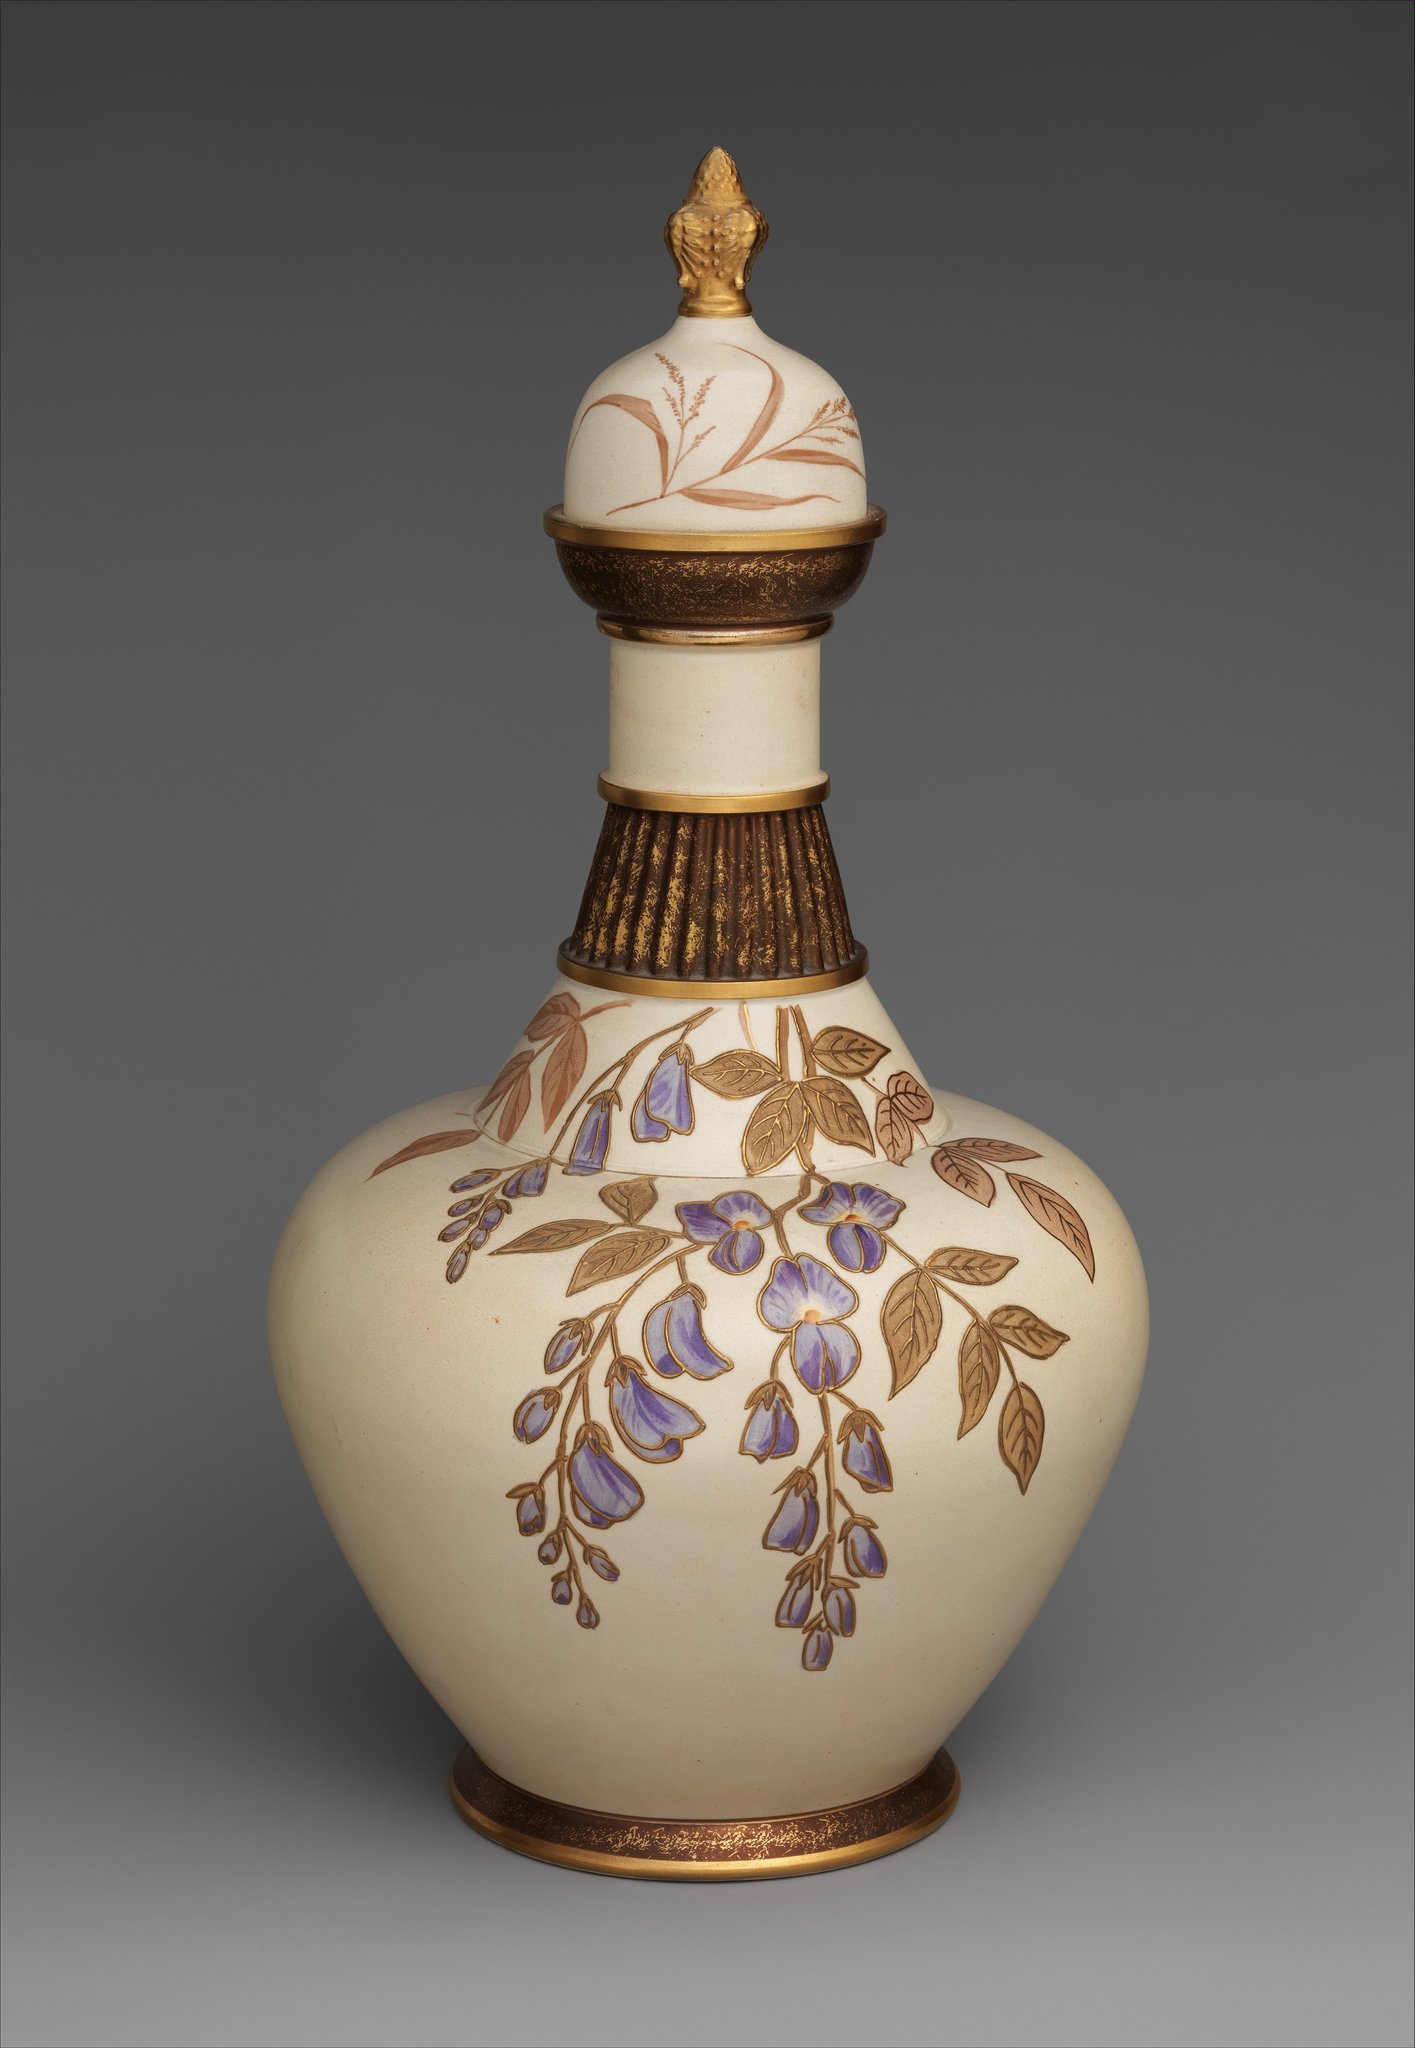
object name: vase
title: Covered Vase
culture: american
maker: faience manufacturing company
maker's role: maker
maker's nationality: american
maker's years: 1881-1892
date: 1886-1890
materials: earthenware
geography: united states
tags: flowers